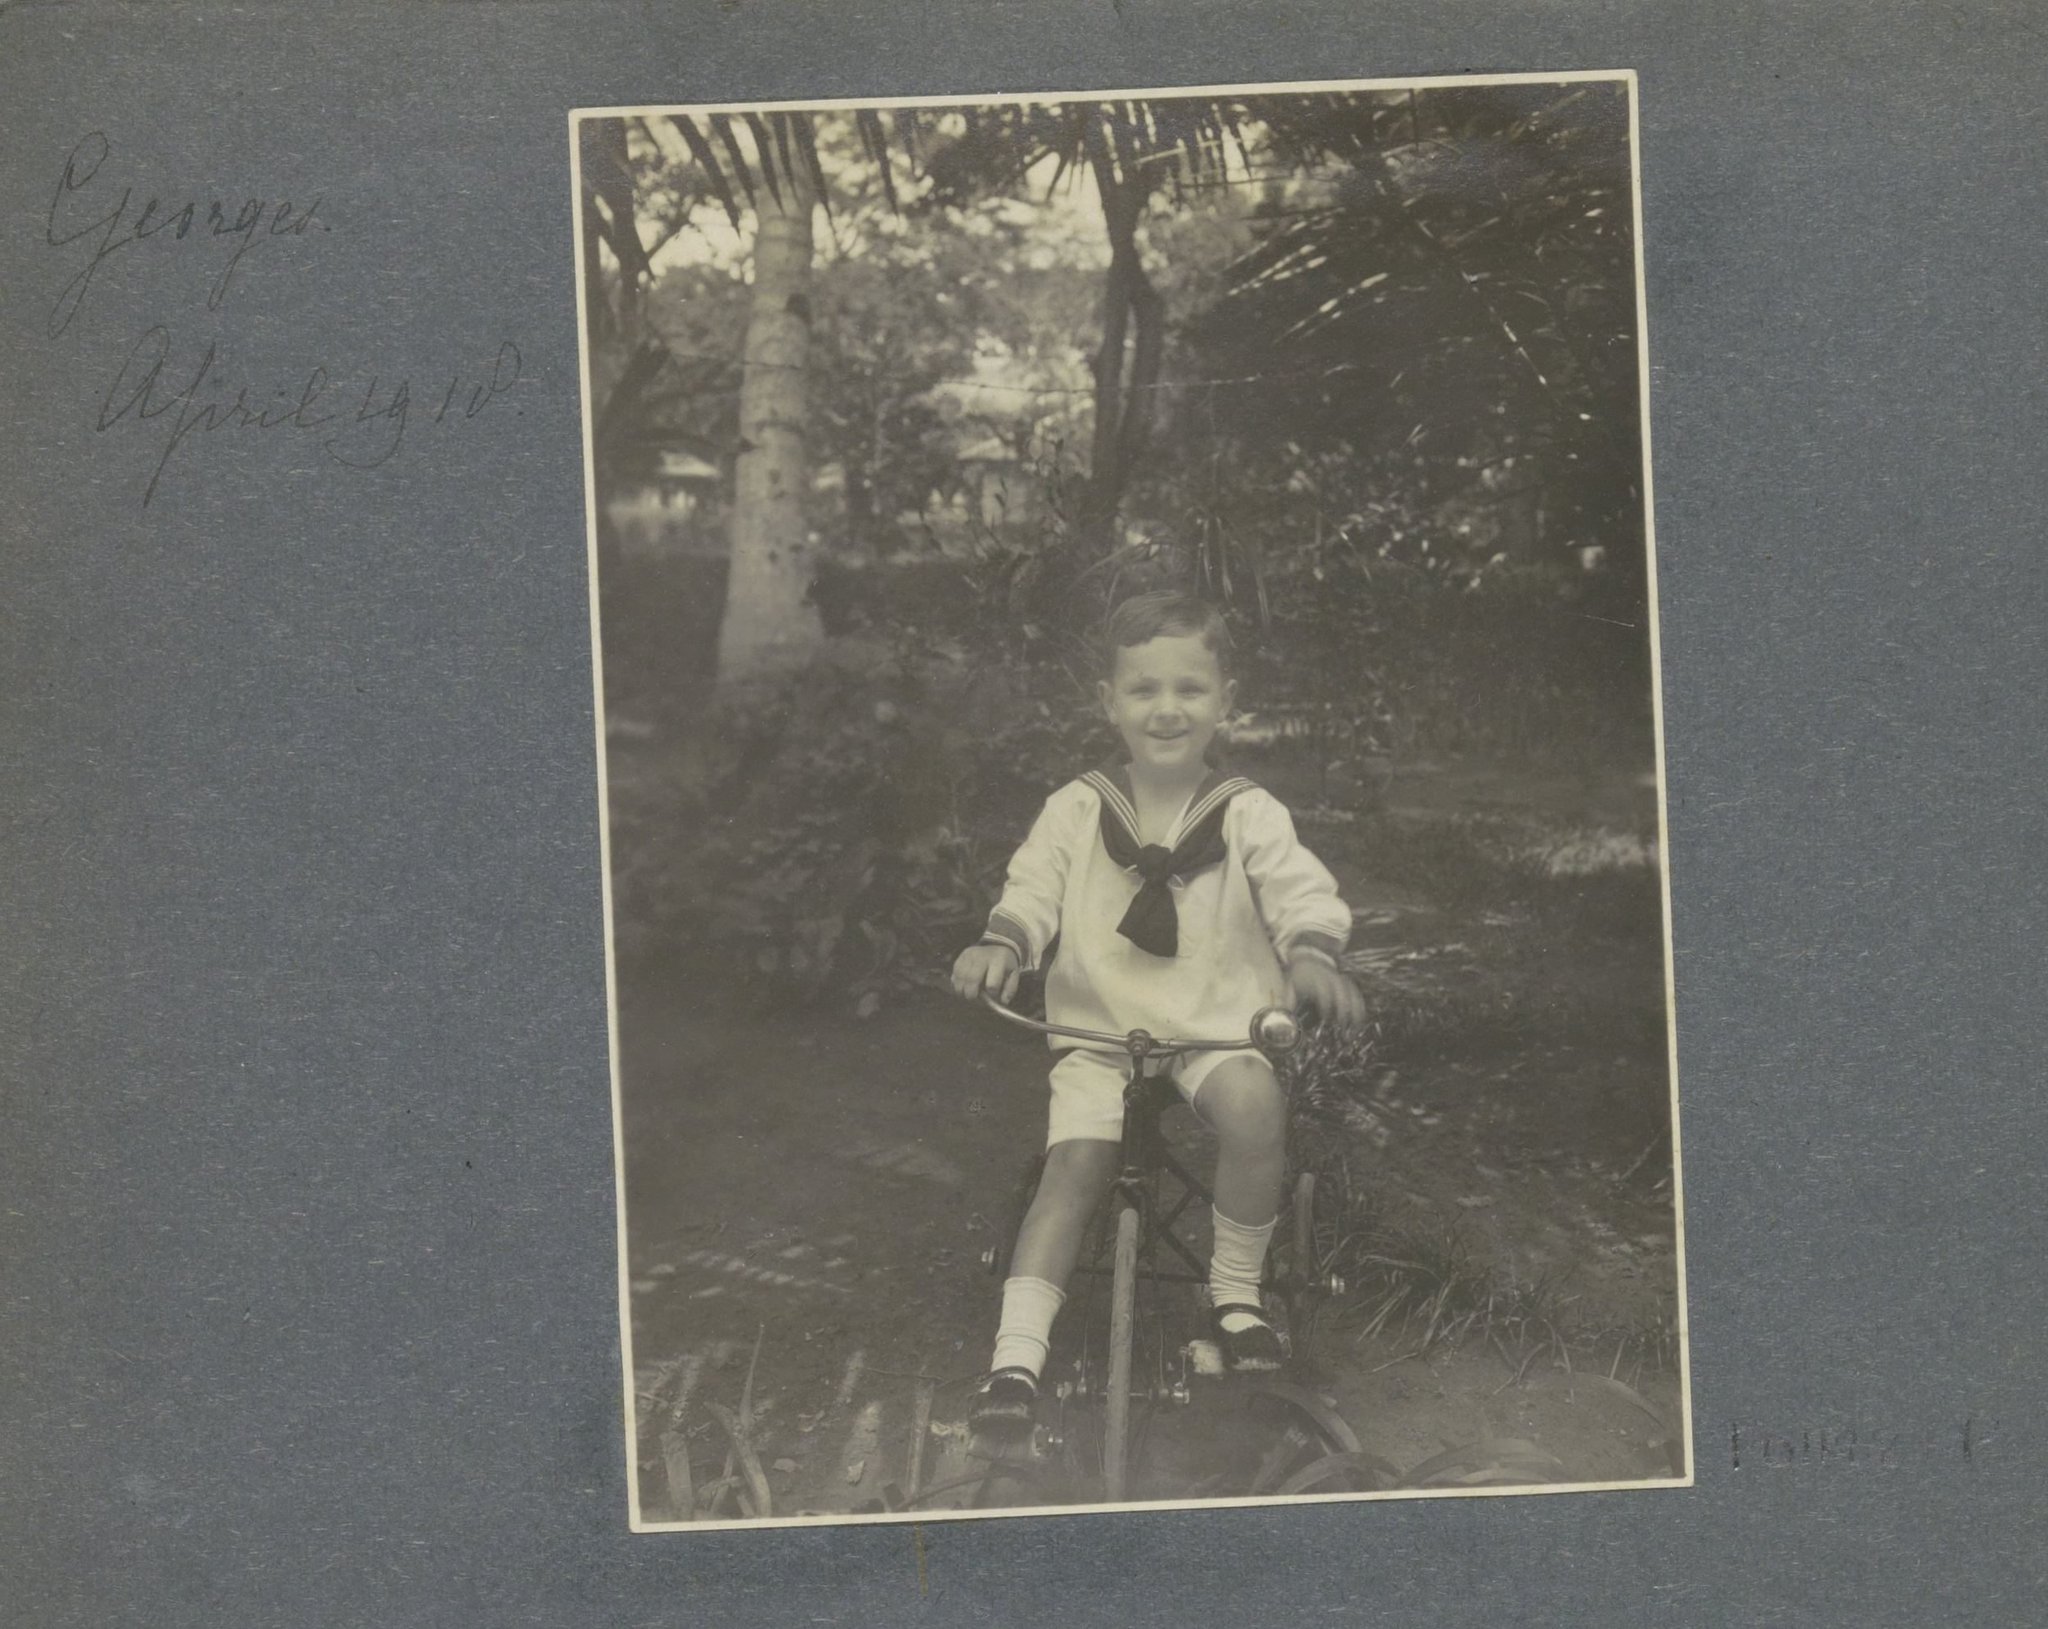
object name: photograph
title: Georges Bergsma op driewieler in tuin op Sumatra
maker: Anonymous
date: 1904-1918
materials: photographic support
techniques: gelatin silver print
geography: sumatra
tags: utrecht, tricycle, child, sumatra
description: Onderdeel van fotoalbum met opnames van de familie Bergsma in Tandjong Poera en Rantan Pandjang (Sumatra).